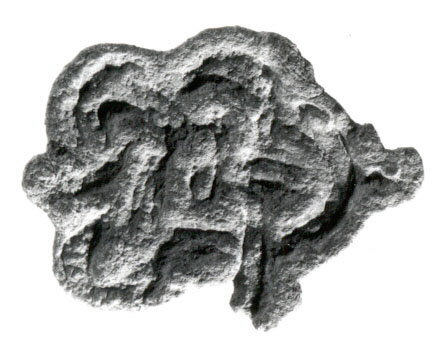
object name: stamp seal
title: Stamp seal with snake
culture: bactria-margiana archaeological complex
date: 2333-1668 BCE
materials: copper alloy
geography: bactria-margiana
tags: snakes